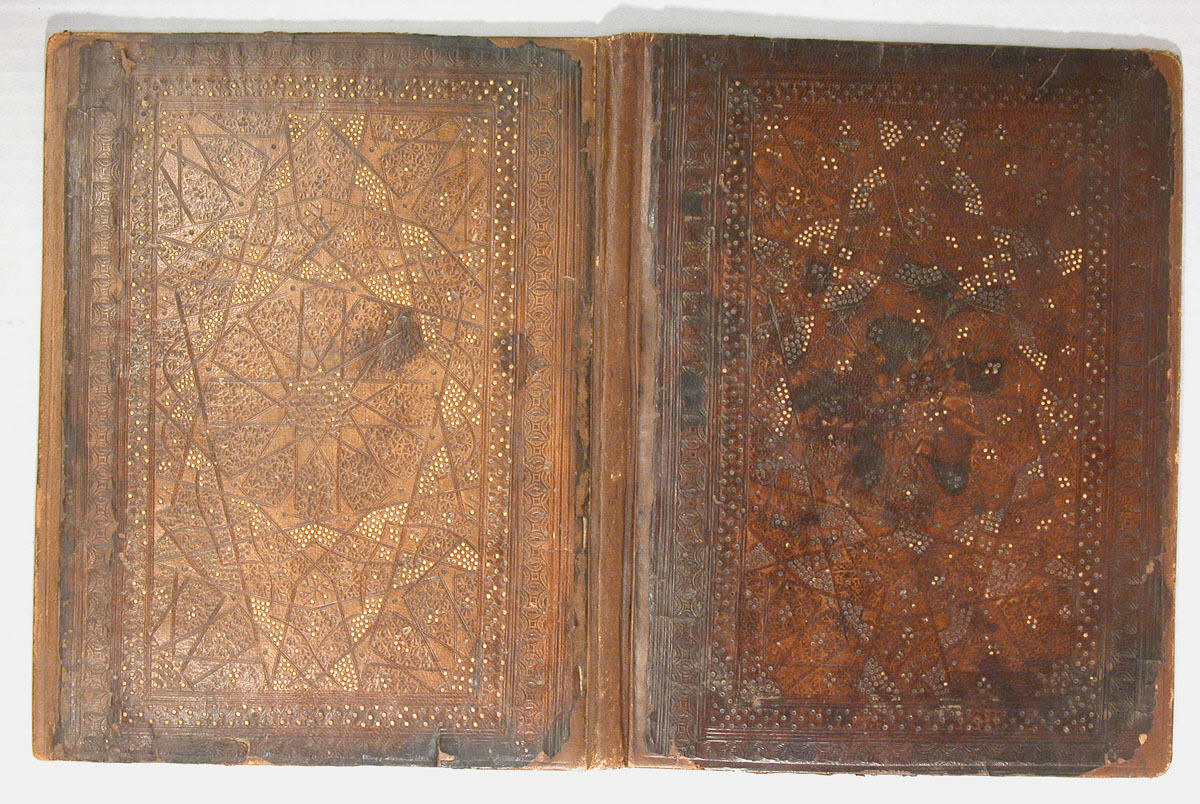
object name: bookbinding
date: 1301-1350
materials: leather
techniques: gilding, stamping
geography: egypt or syria